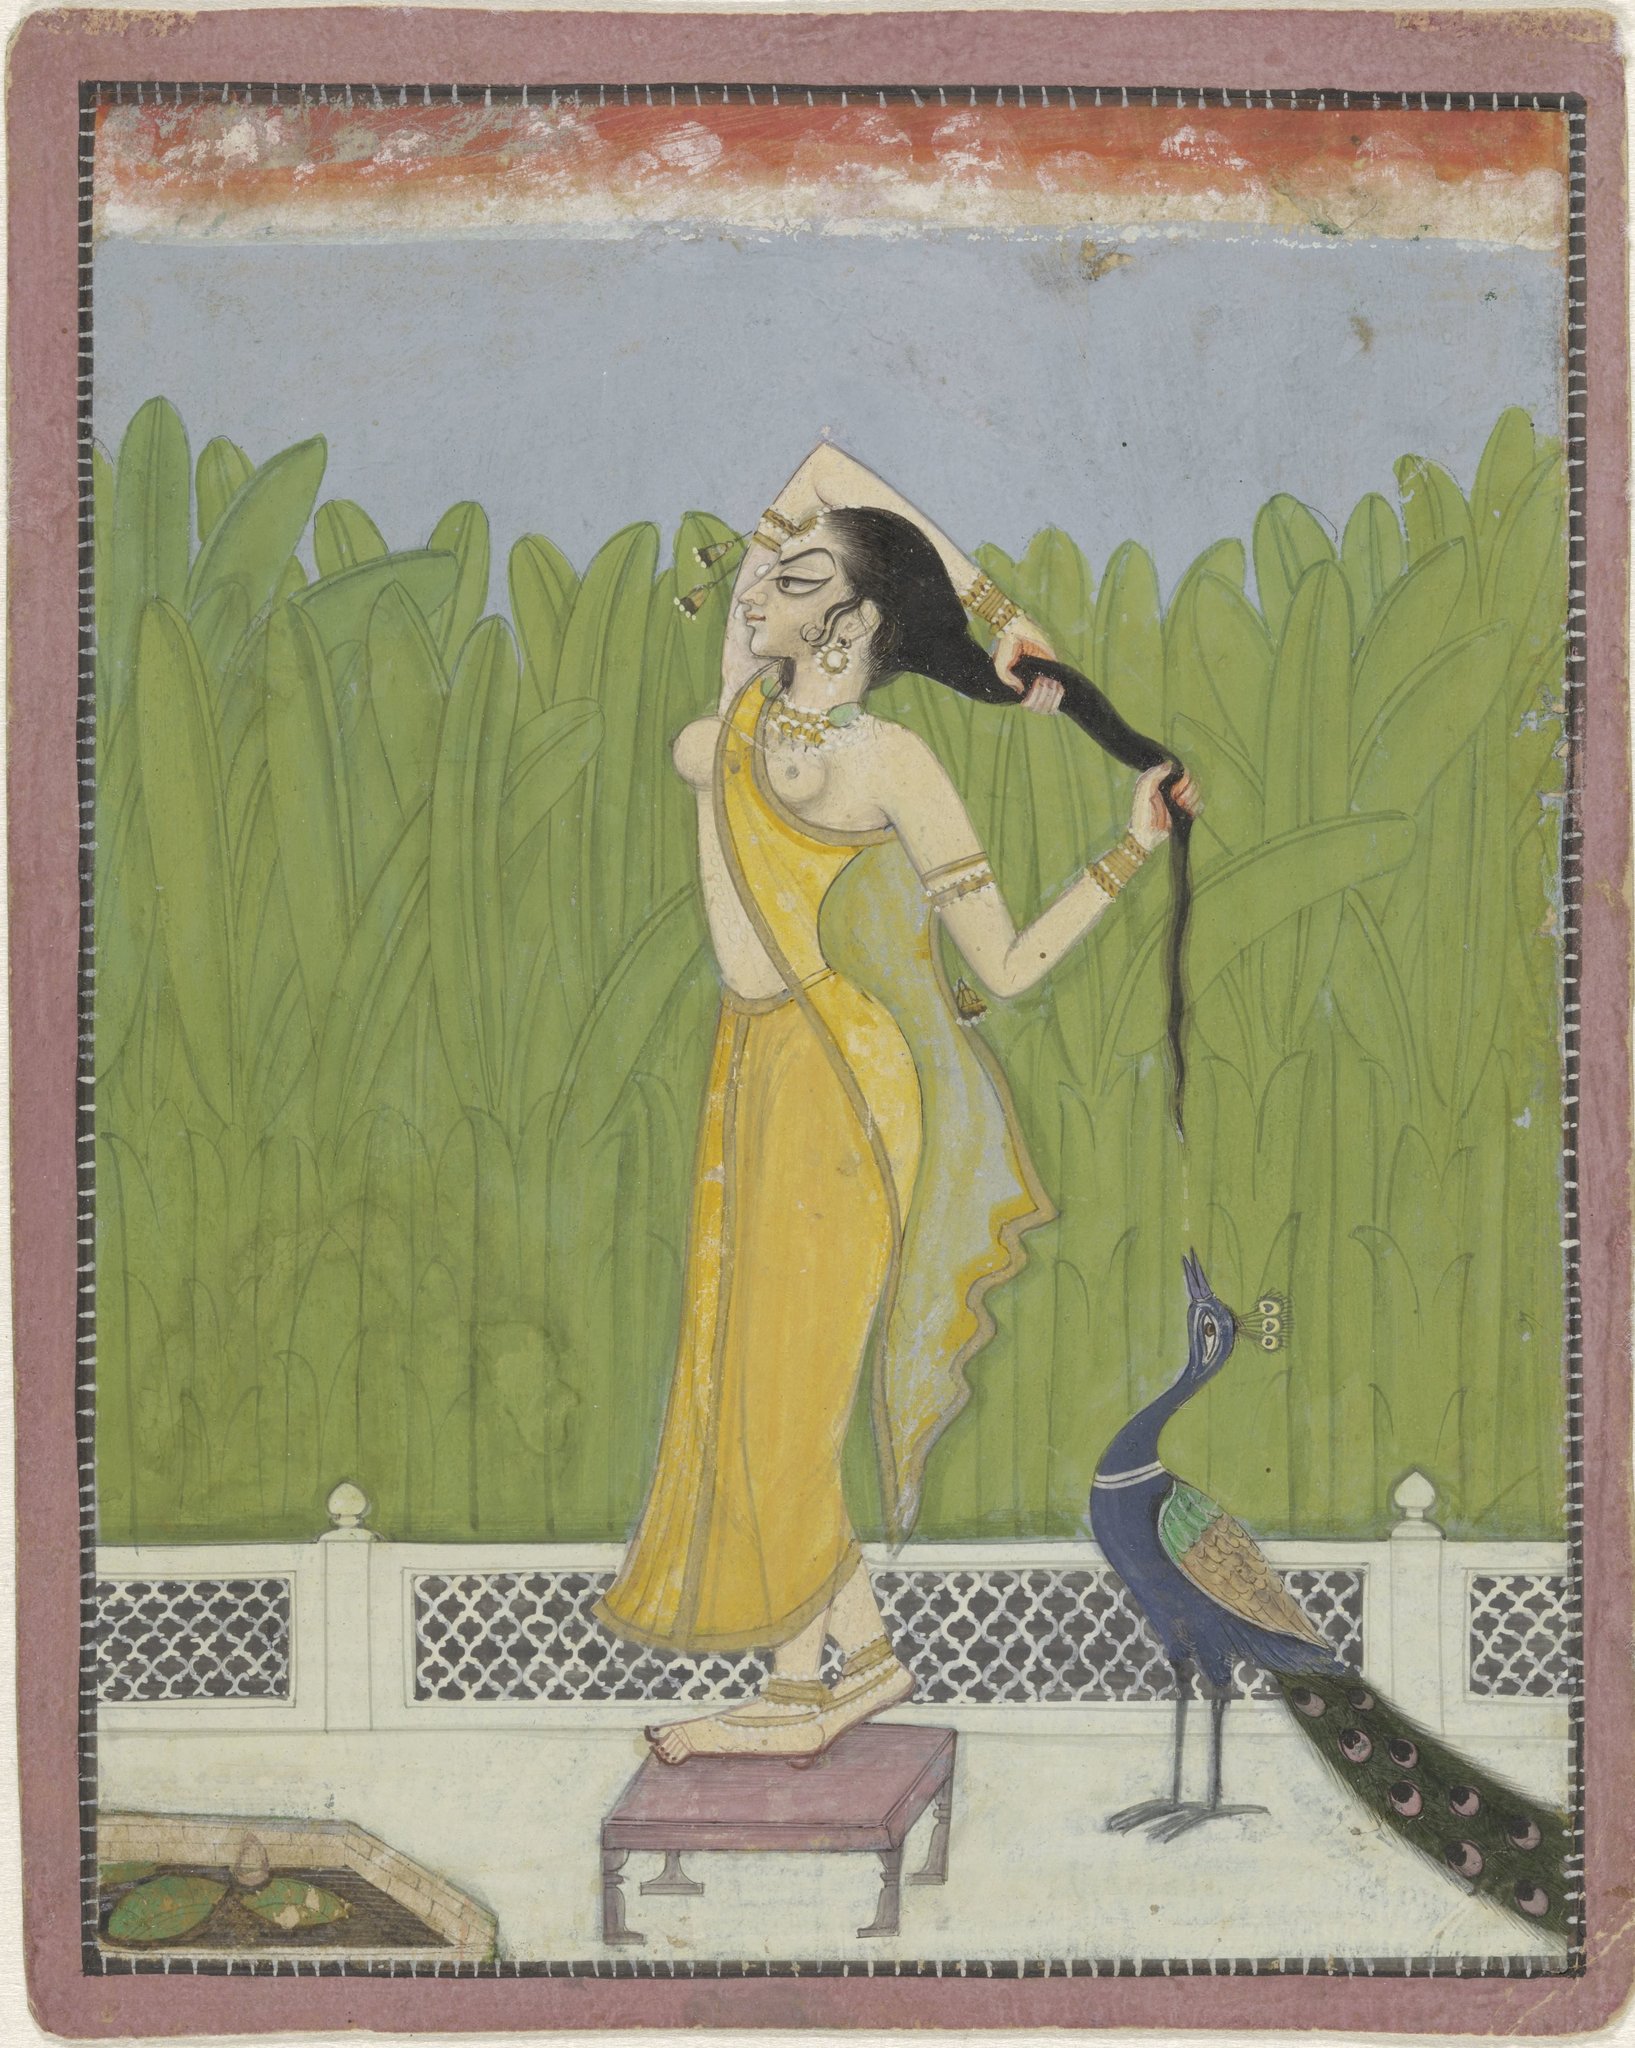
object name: drawing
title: A woman drying her hair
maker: Anonymous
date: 1790-1810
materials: gouache, paper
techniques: brush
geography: kishangarh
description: A woman stands on a low stool and wrings out her hair after a bath. A peacock on the terrace stretches its neck to catch the drops of water. The peacock is a symbolic representation of the lover and refers to a number of sayings. Long and thick hair was considered an important characteristic of beauty, and loose hair had erotic connotations.